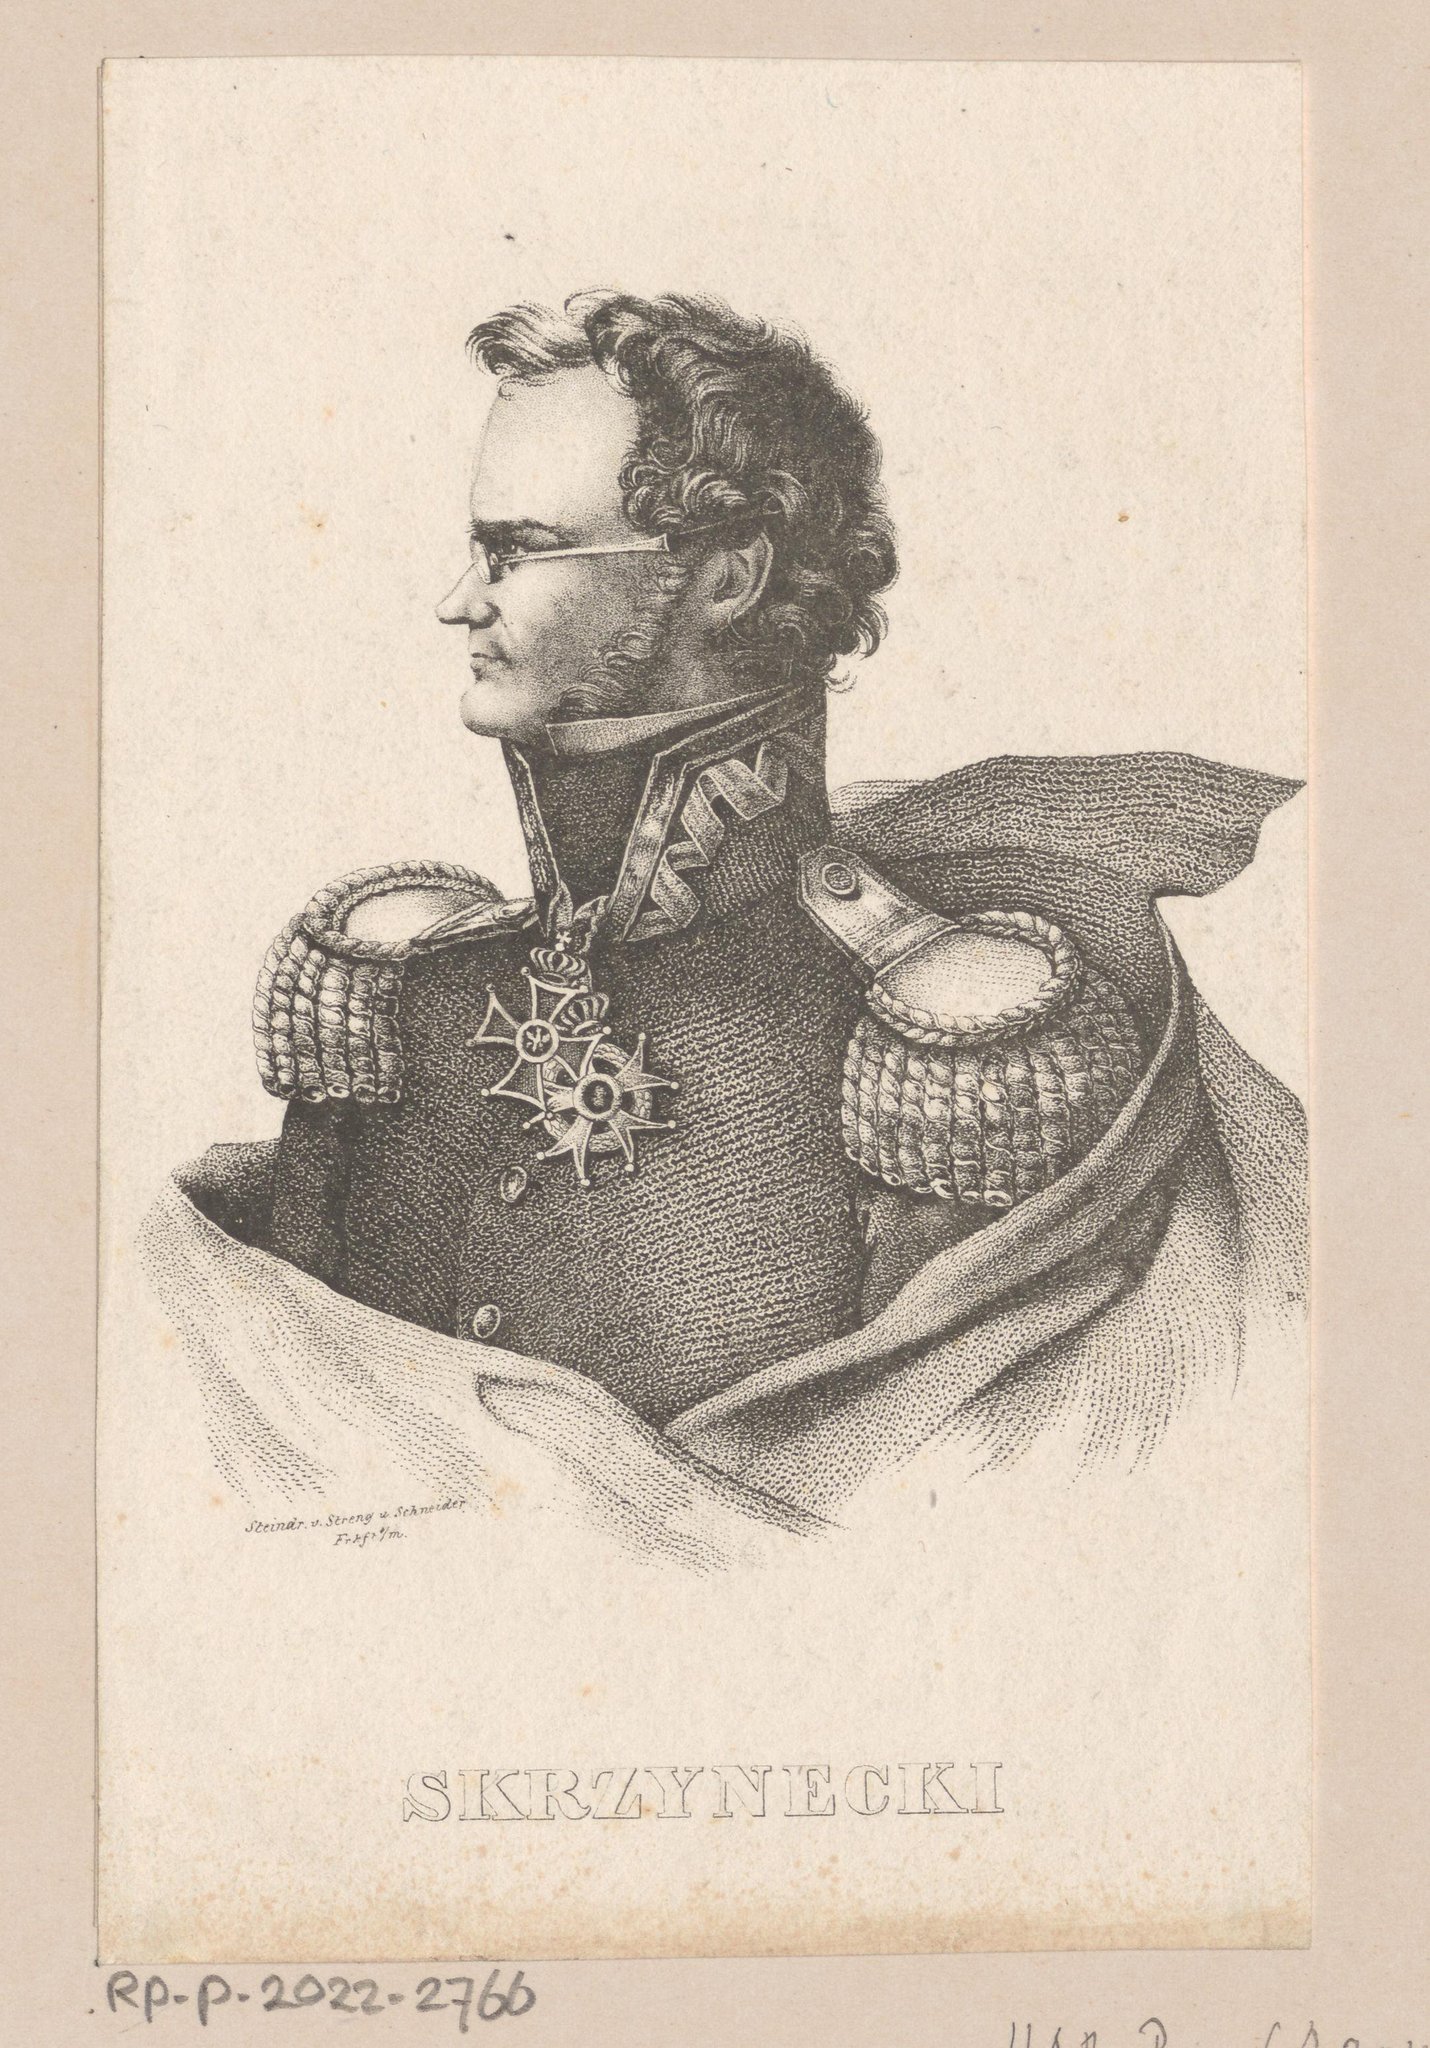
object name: print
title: Portret van Jan Zygmunt Skrzynecki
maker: Anonymous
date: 1809-1899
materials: paper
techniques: lithograph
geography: frankfurt am main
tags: commander-in-chief, general, marshal, historical persons